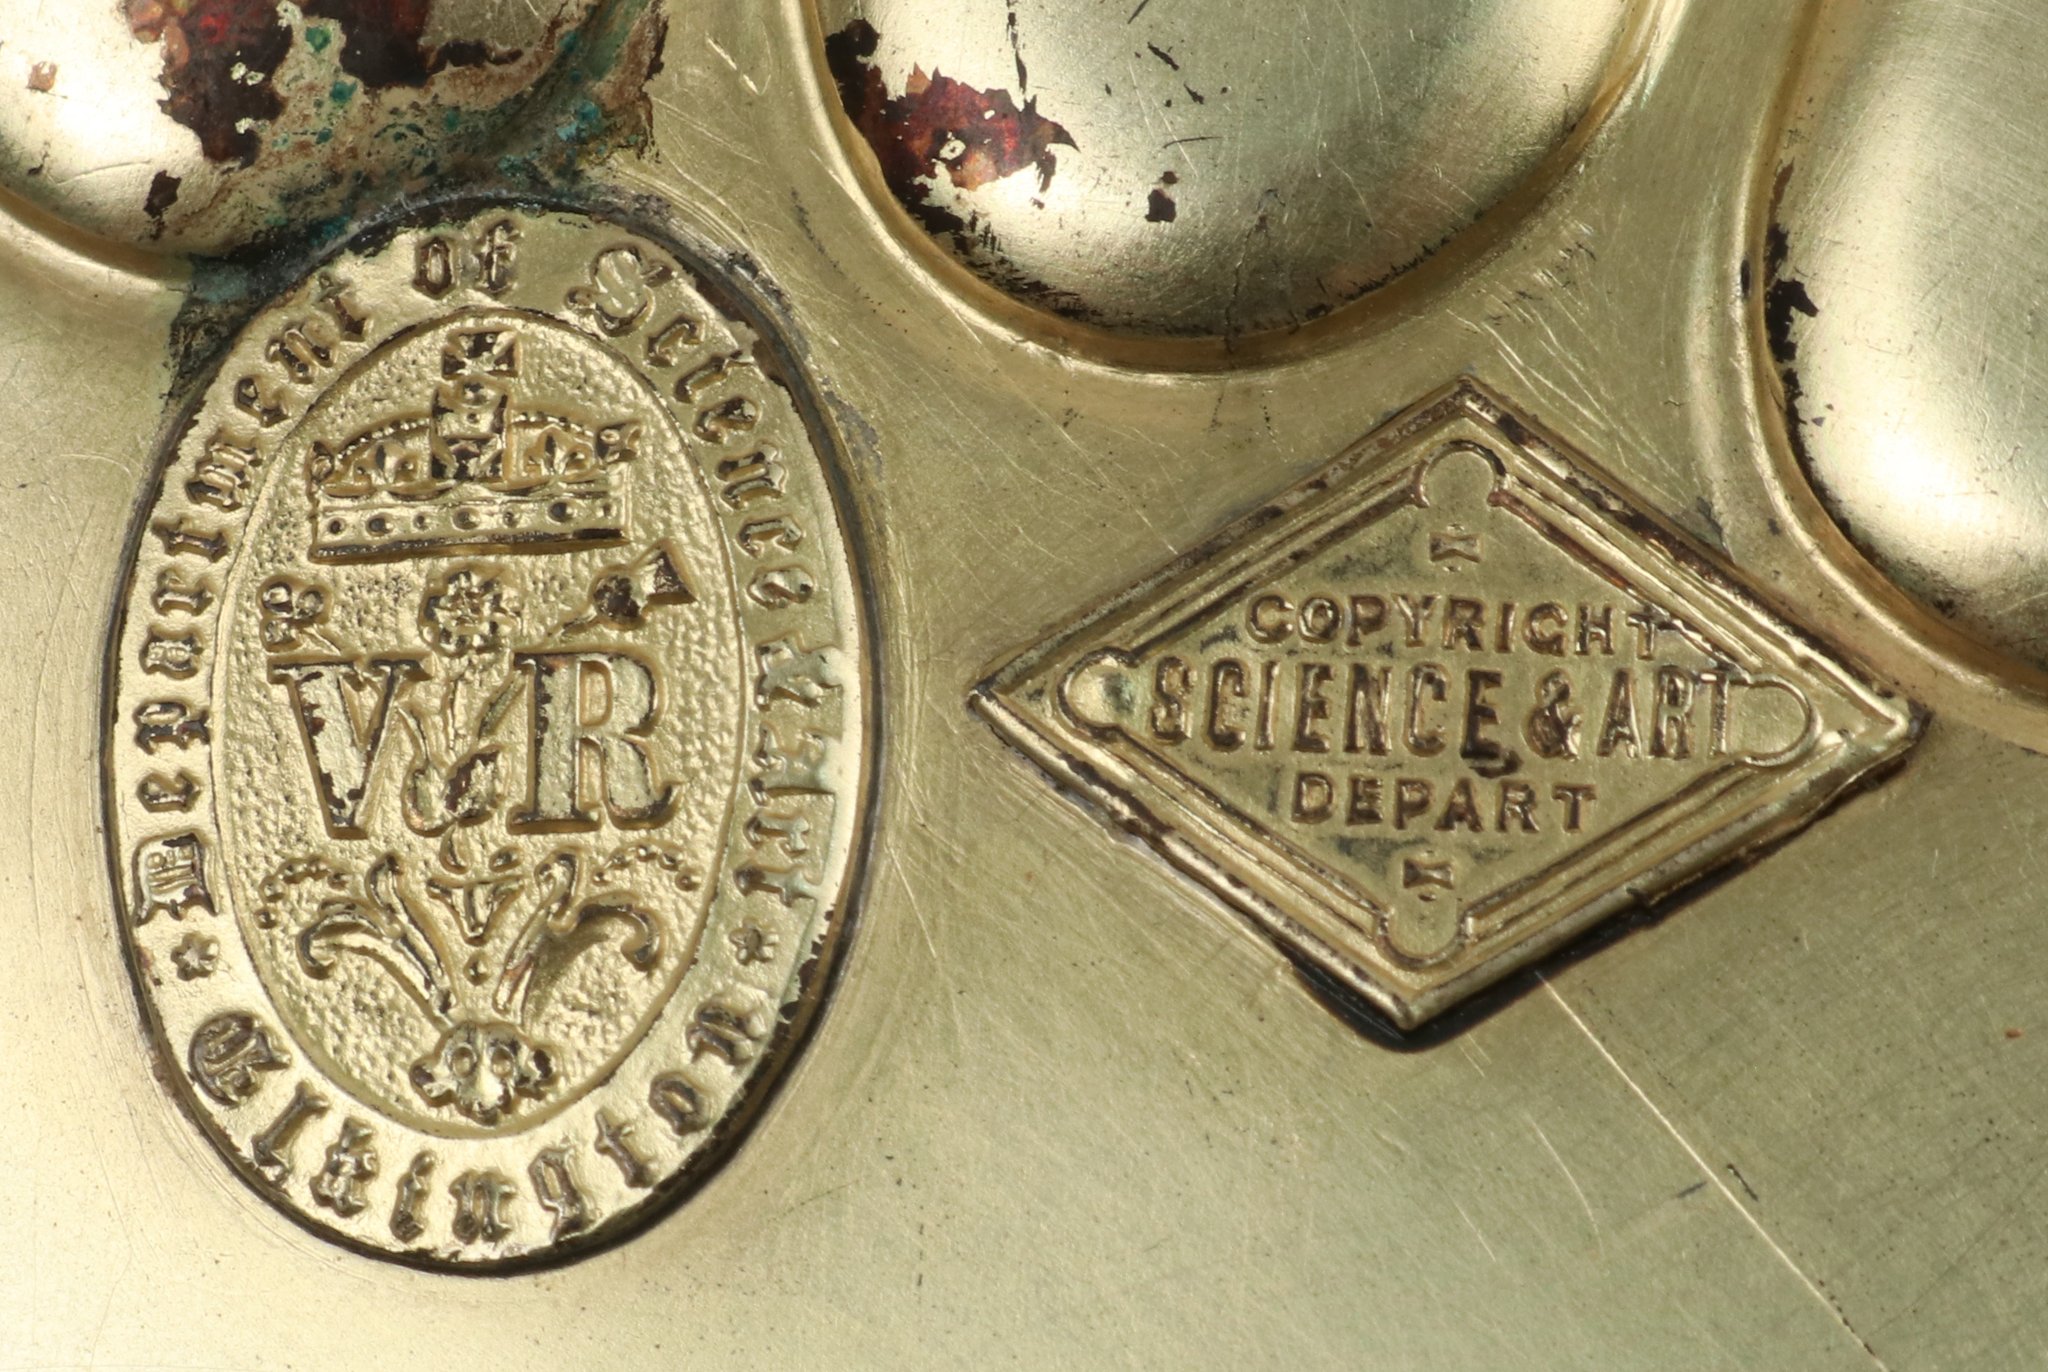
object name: bowl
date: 1801-1900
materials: metal, silver